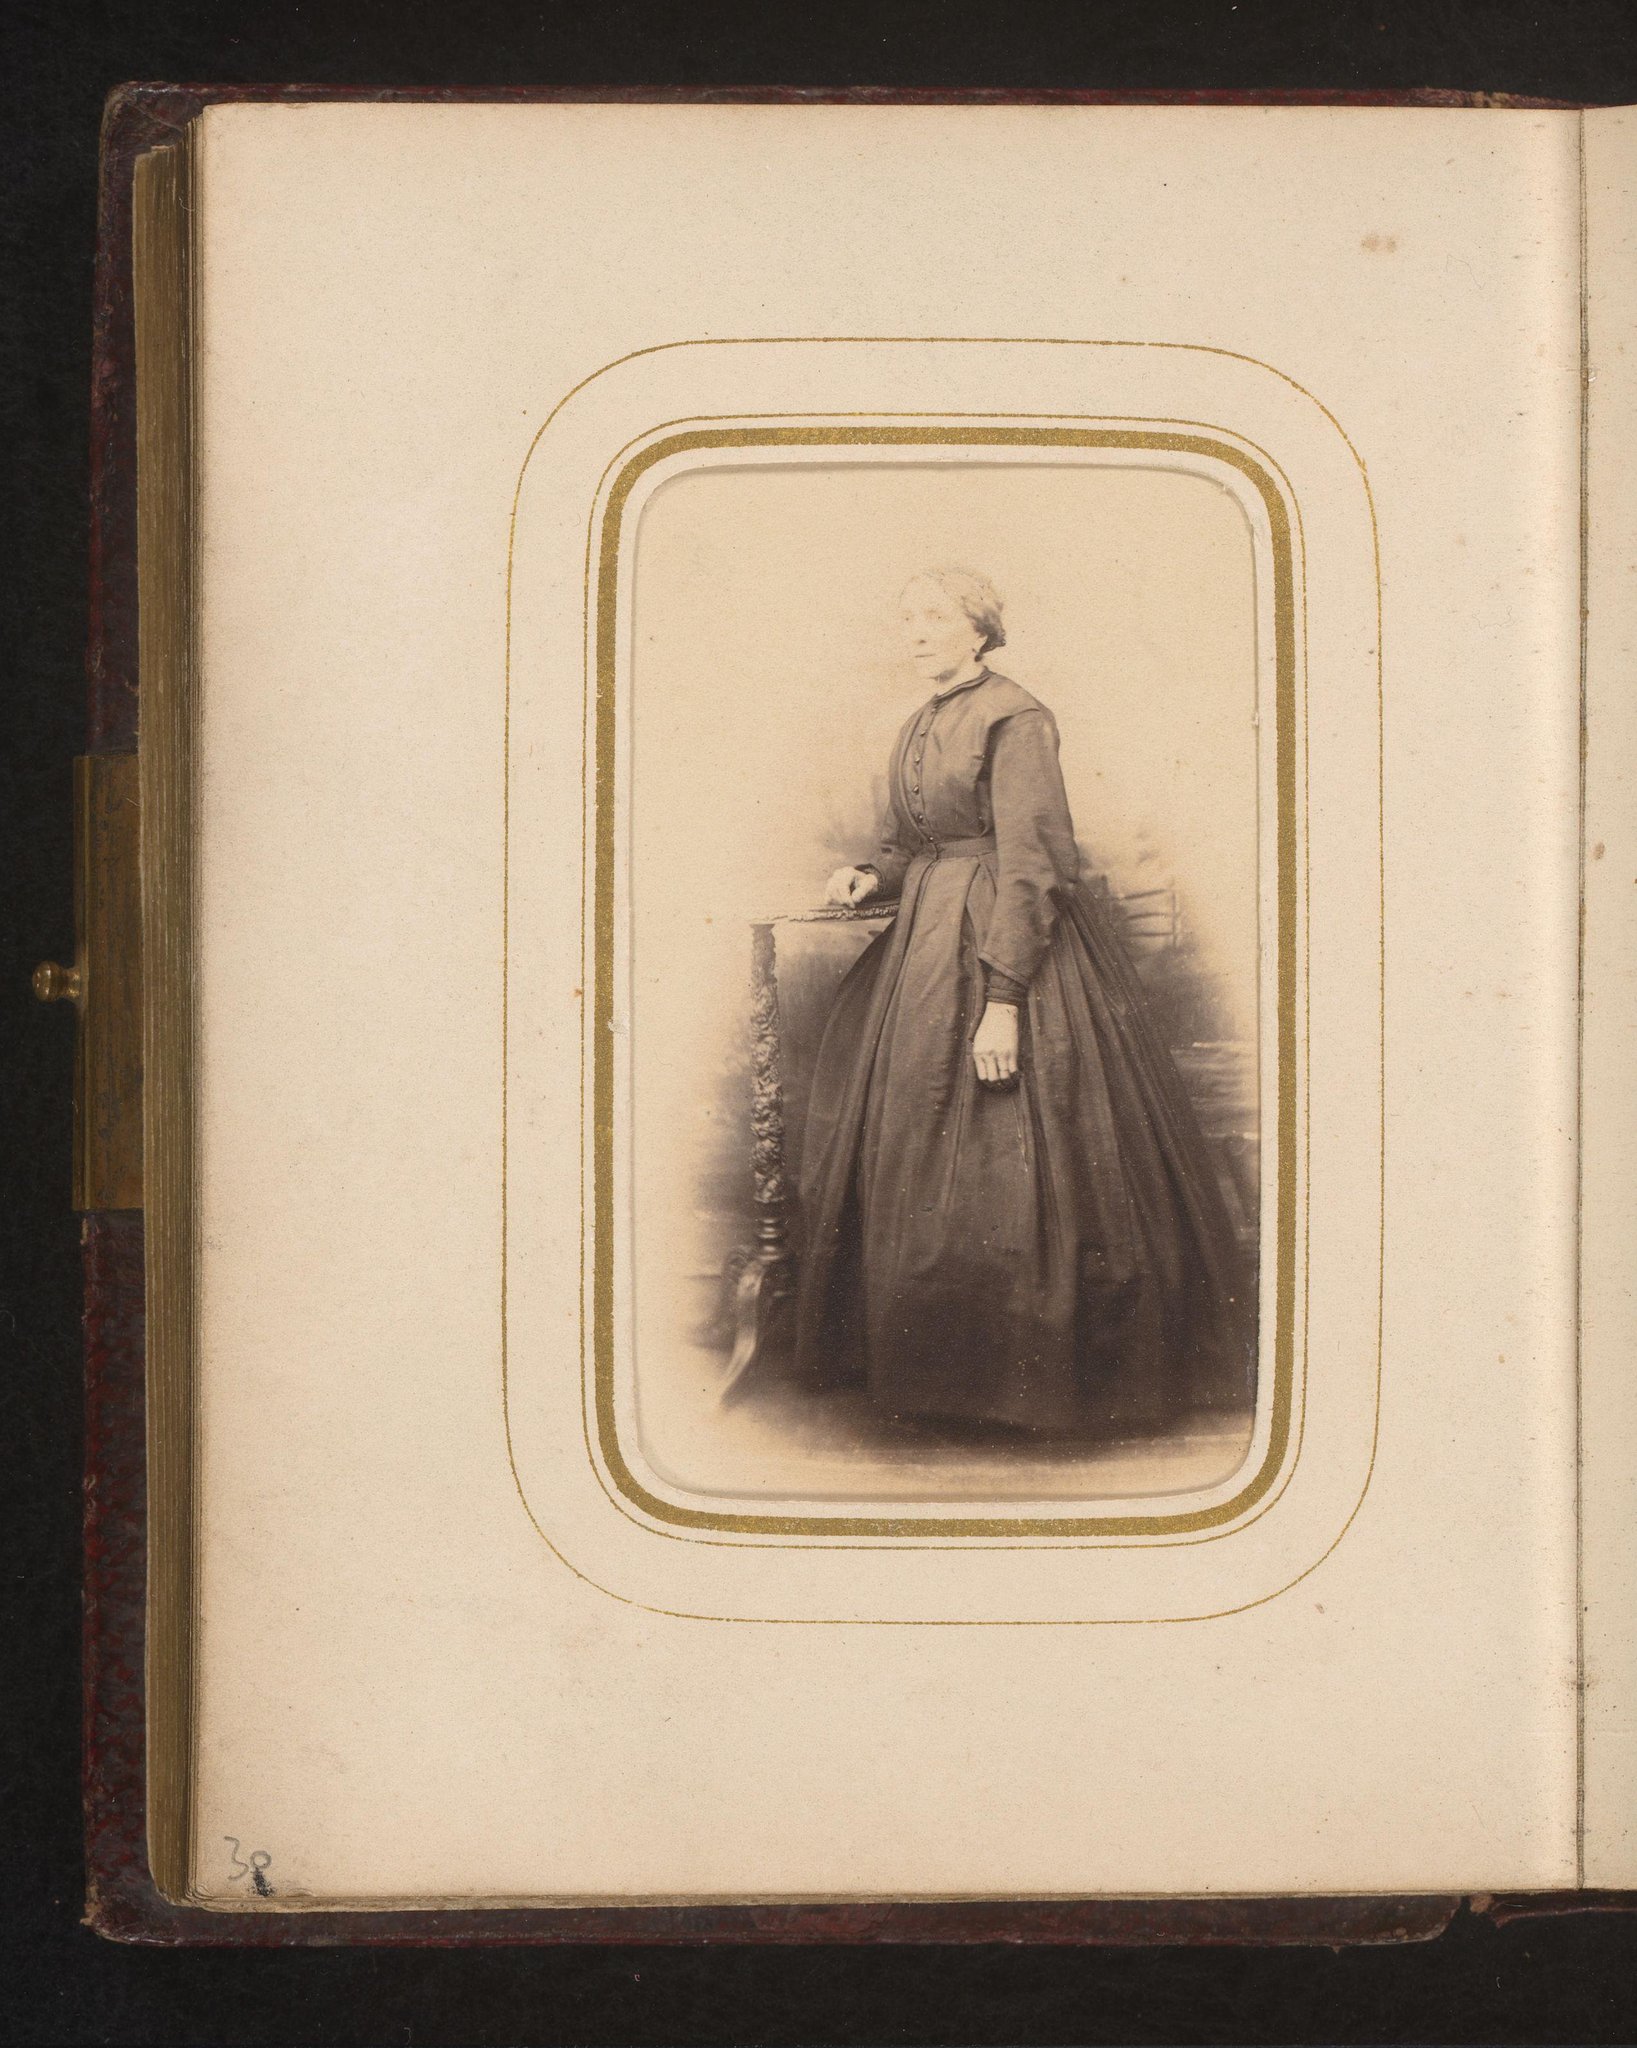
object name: photograph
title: Portret van een oude vrouw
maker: andré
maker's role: fotograaf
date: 1860-1900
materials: cardboard, photographic support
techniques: albumen print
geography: paris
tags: old woman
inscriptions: inscription: ‘André, Photographe/ 104, Rue des Dames, à Batignolles’